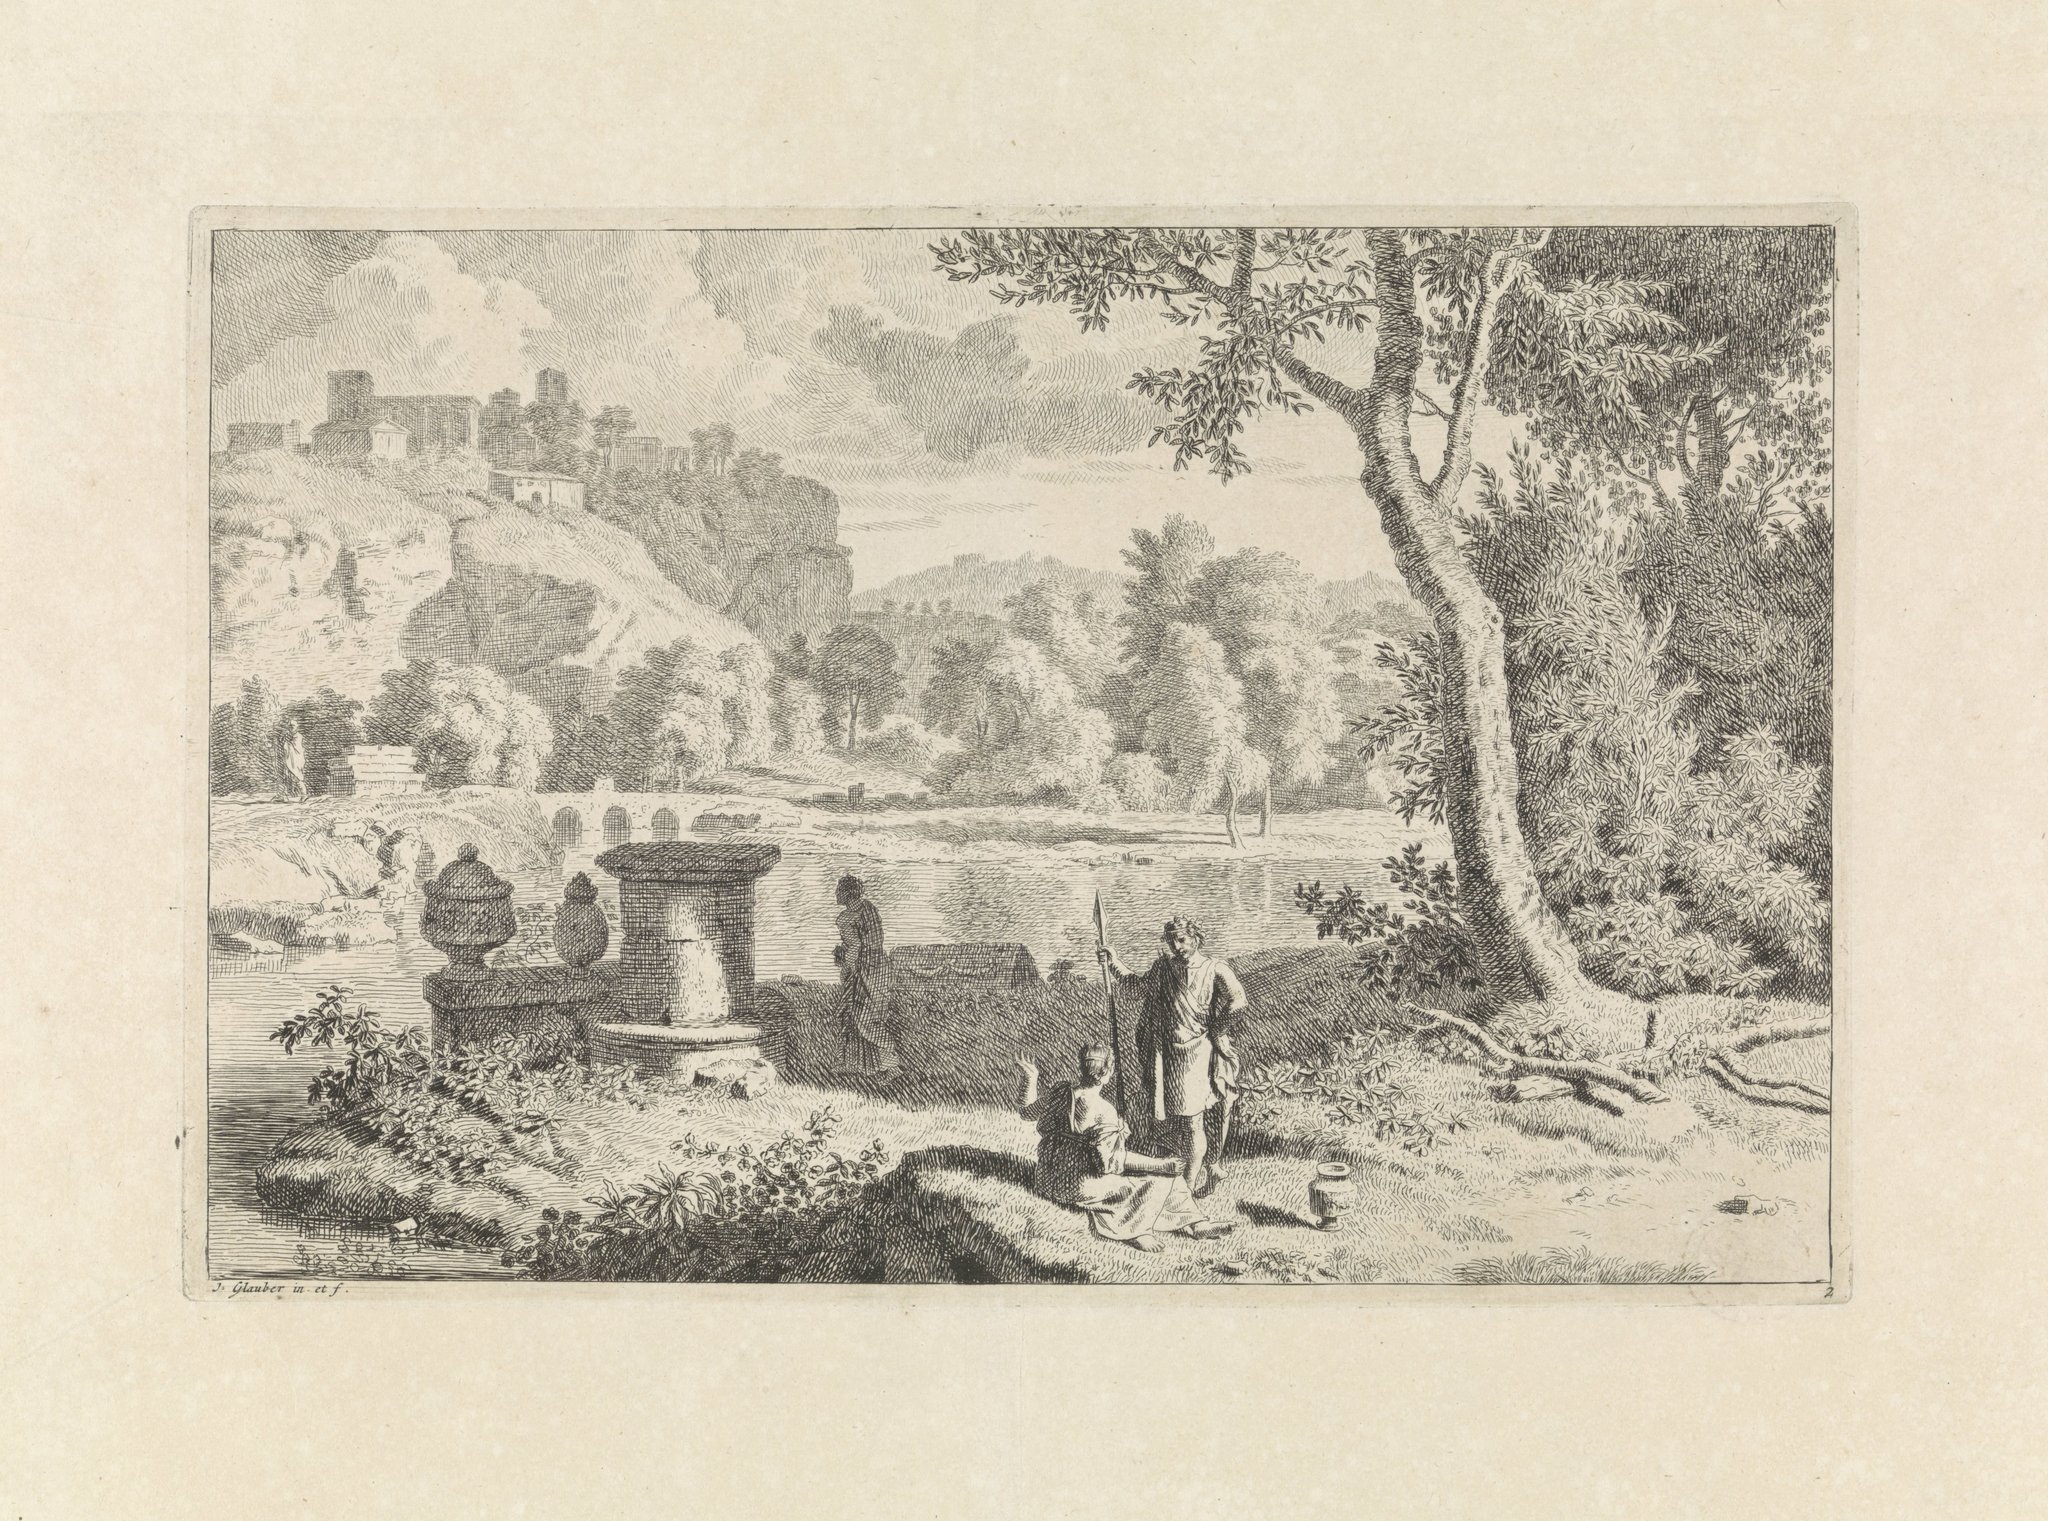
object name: print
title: Arcadisch landschap met een rivier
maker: johannes glauber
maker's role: draughtsman, painter, print maker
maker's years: 1646-1726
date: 1656-1726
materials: paper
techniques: etching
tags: river, landscape with ruins (+ city(-scape) with figures, staffage), pastorals, arcadian scenes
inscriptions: collector's mark: Lugt 240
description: Een arcadisch landschap met een rivier. Langs de oever ruïnes. Op de voorgrond een man met een speer en een zittende vrouw. Beiden zijn in Romeinse kleding. Op de achtergrond een stad. De prent maakt deel uit van een serie met arcadische landschappen.